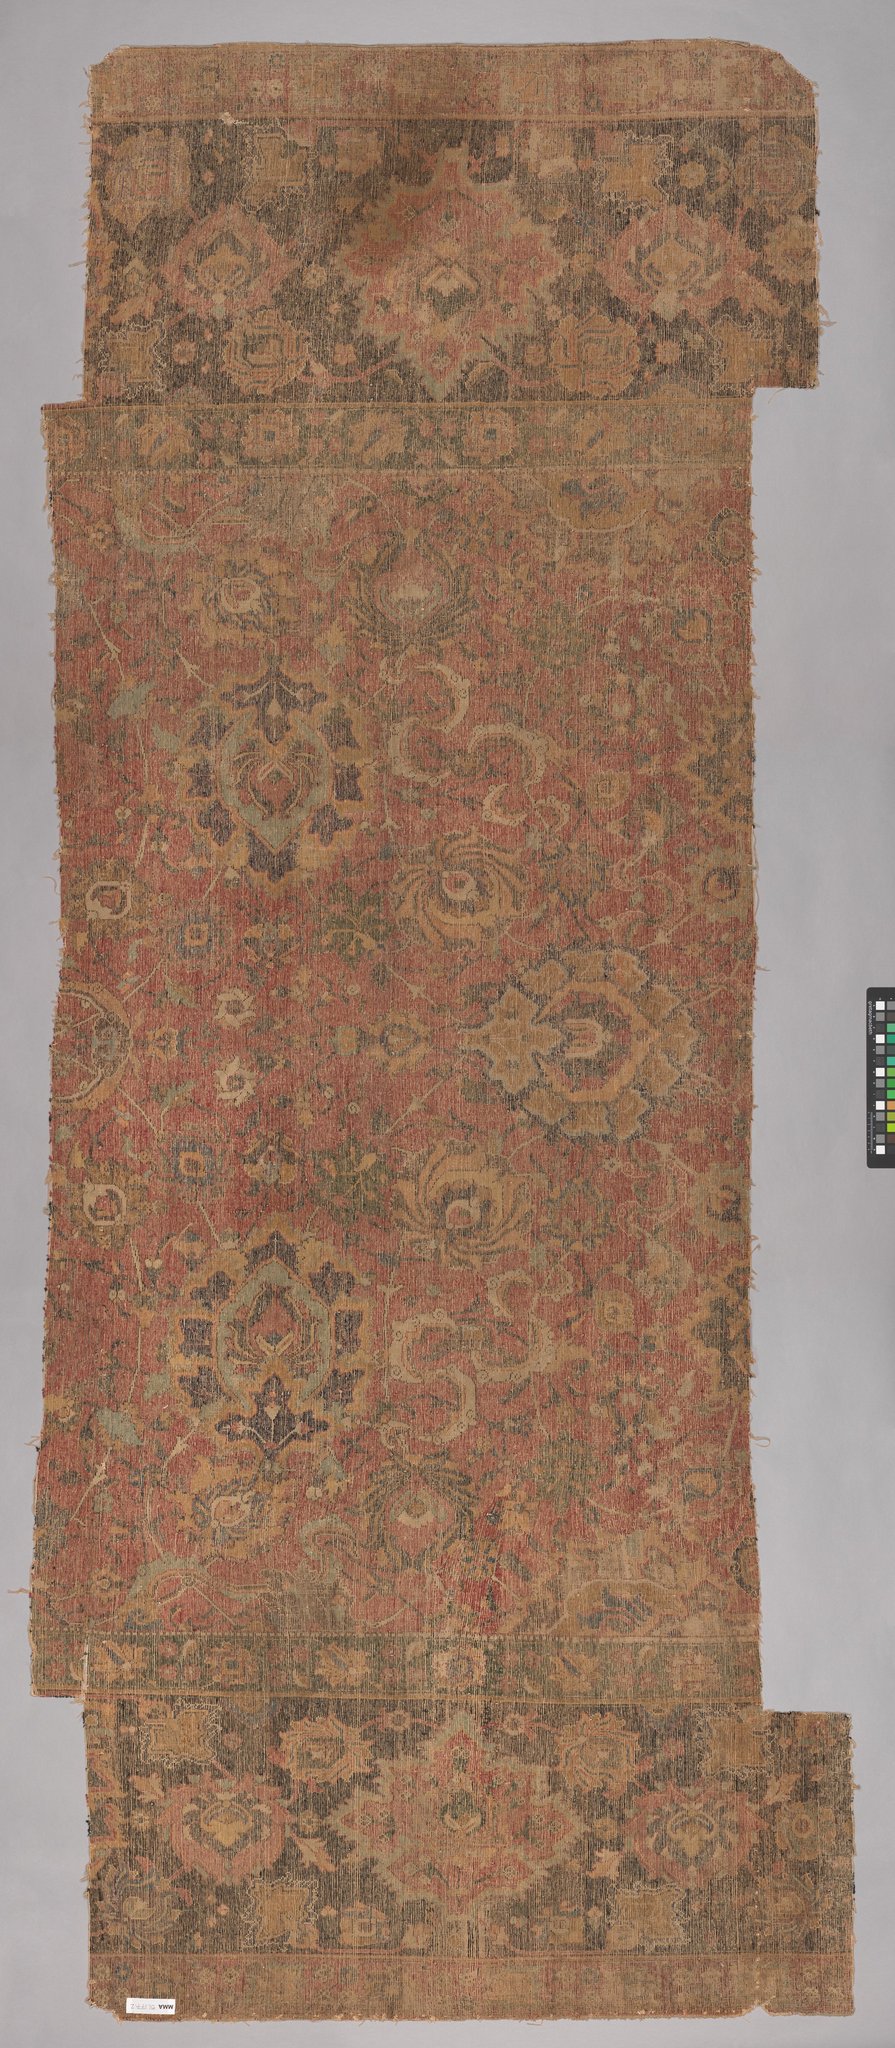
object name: carpet fragment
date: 1601-1700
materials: wool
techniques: asymmetrically knotted pile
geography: iran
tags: flowers